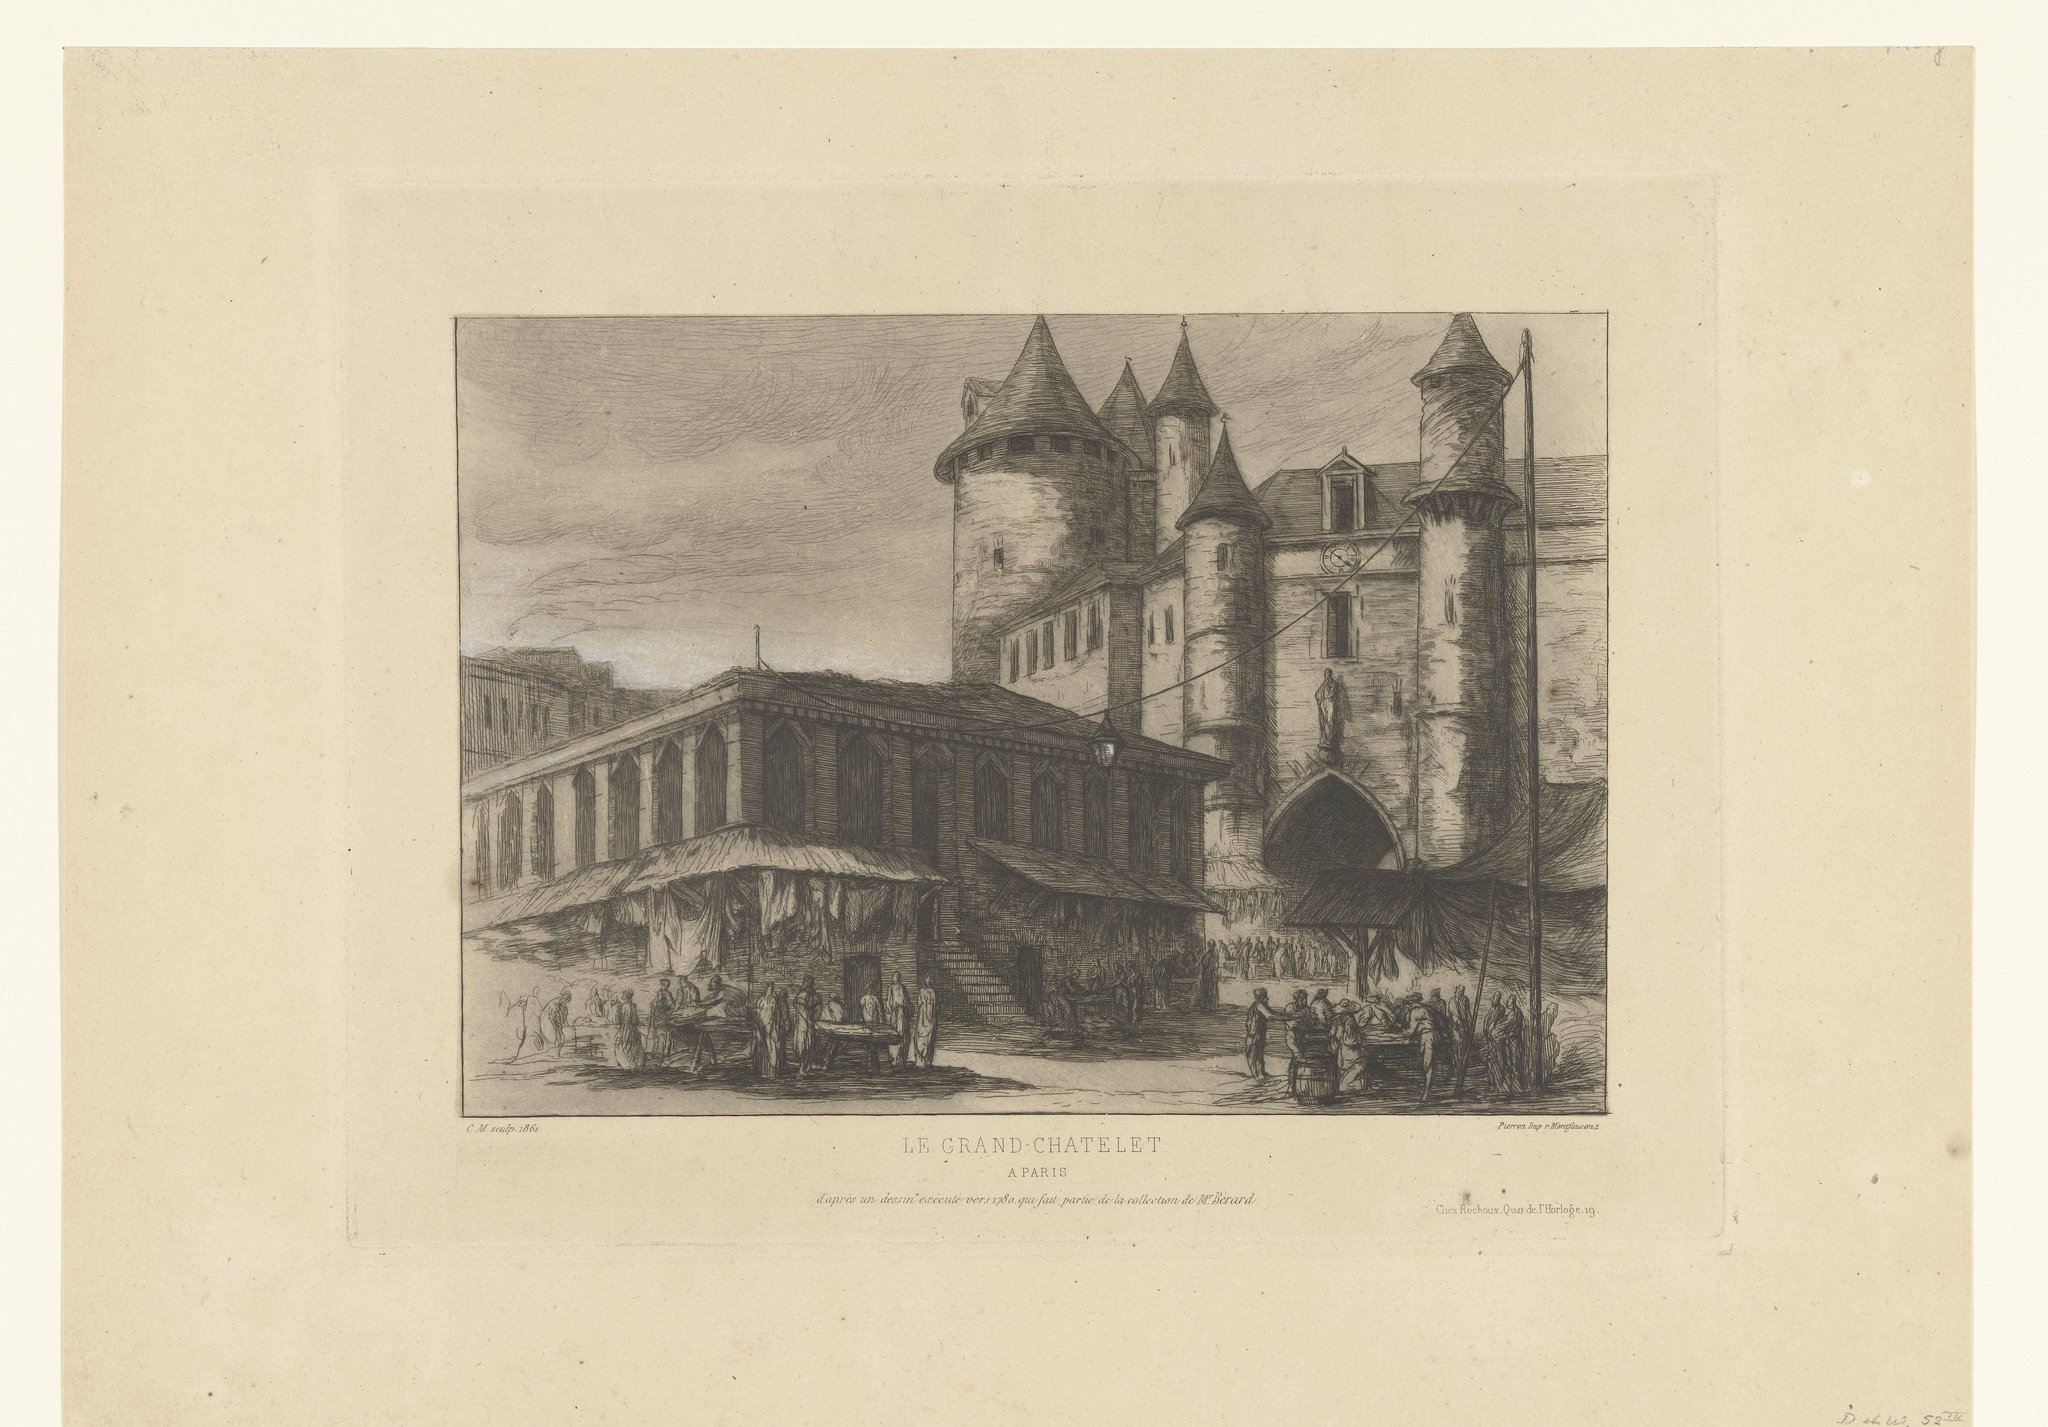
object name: print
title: Le Grand Chatelet à Paris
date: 1861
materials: paint, paper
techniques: drypoint, etching, hand coloring, intaglio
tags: fortress, market, paris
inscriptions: collector's mark: Lugt 2228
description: Het fort Grand Châtelet bij de Pont-au-Change in Parijs in de situatie voordat het in 1860 werd afgebroken. Op het plein voor het fort is het een drukte van belang met verschillende kooplieden op de markt. De kunstenaar gebruikte een anonieme tekening uit circa 1780 als voorbeeld.